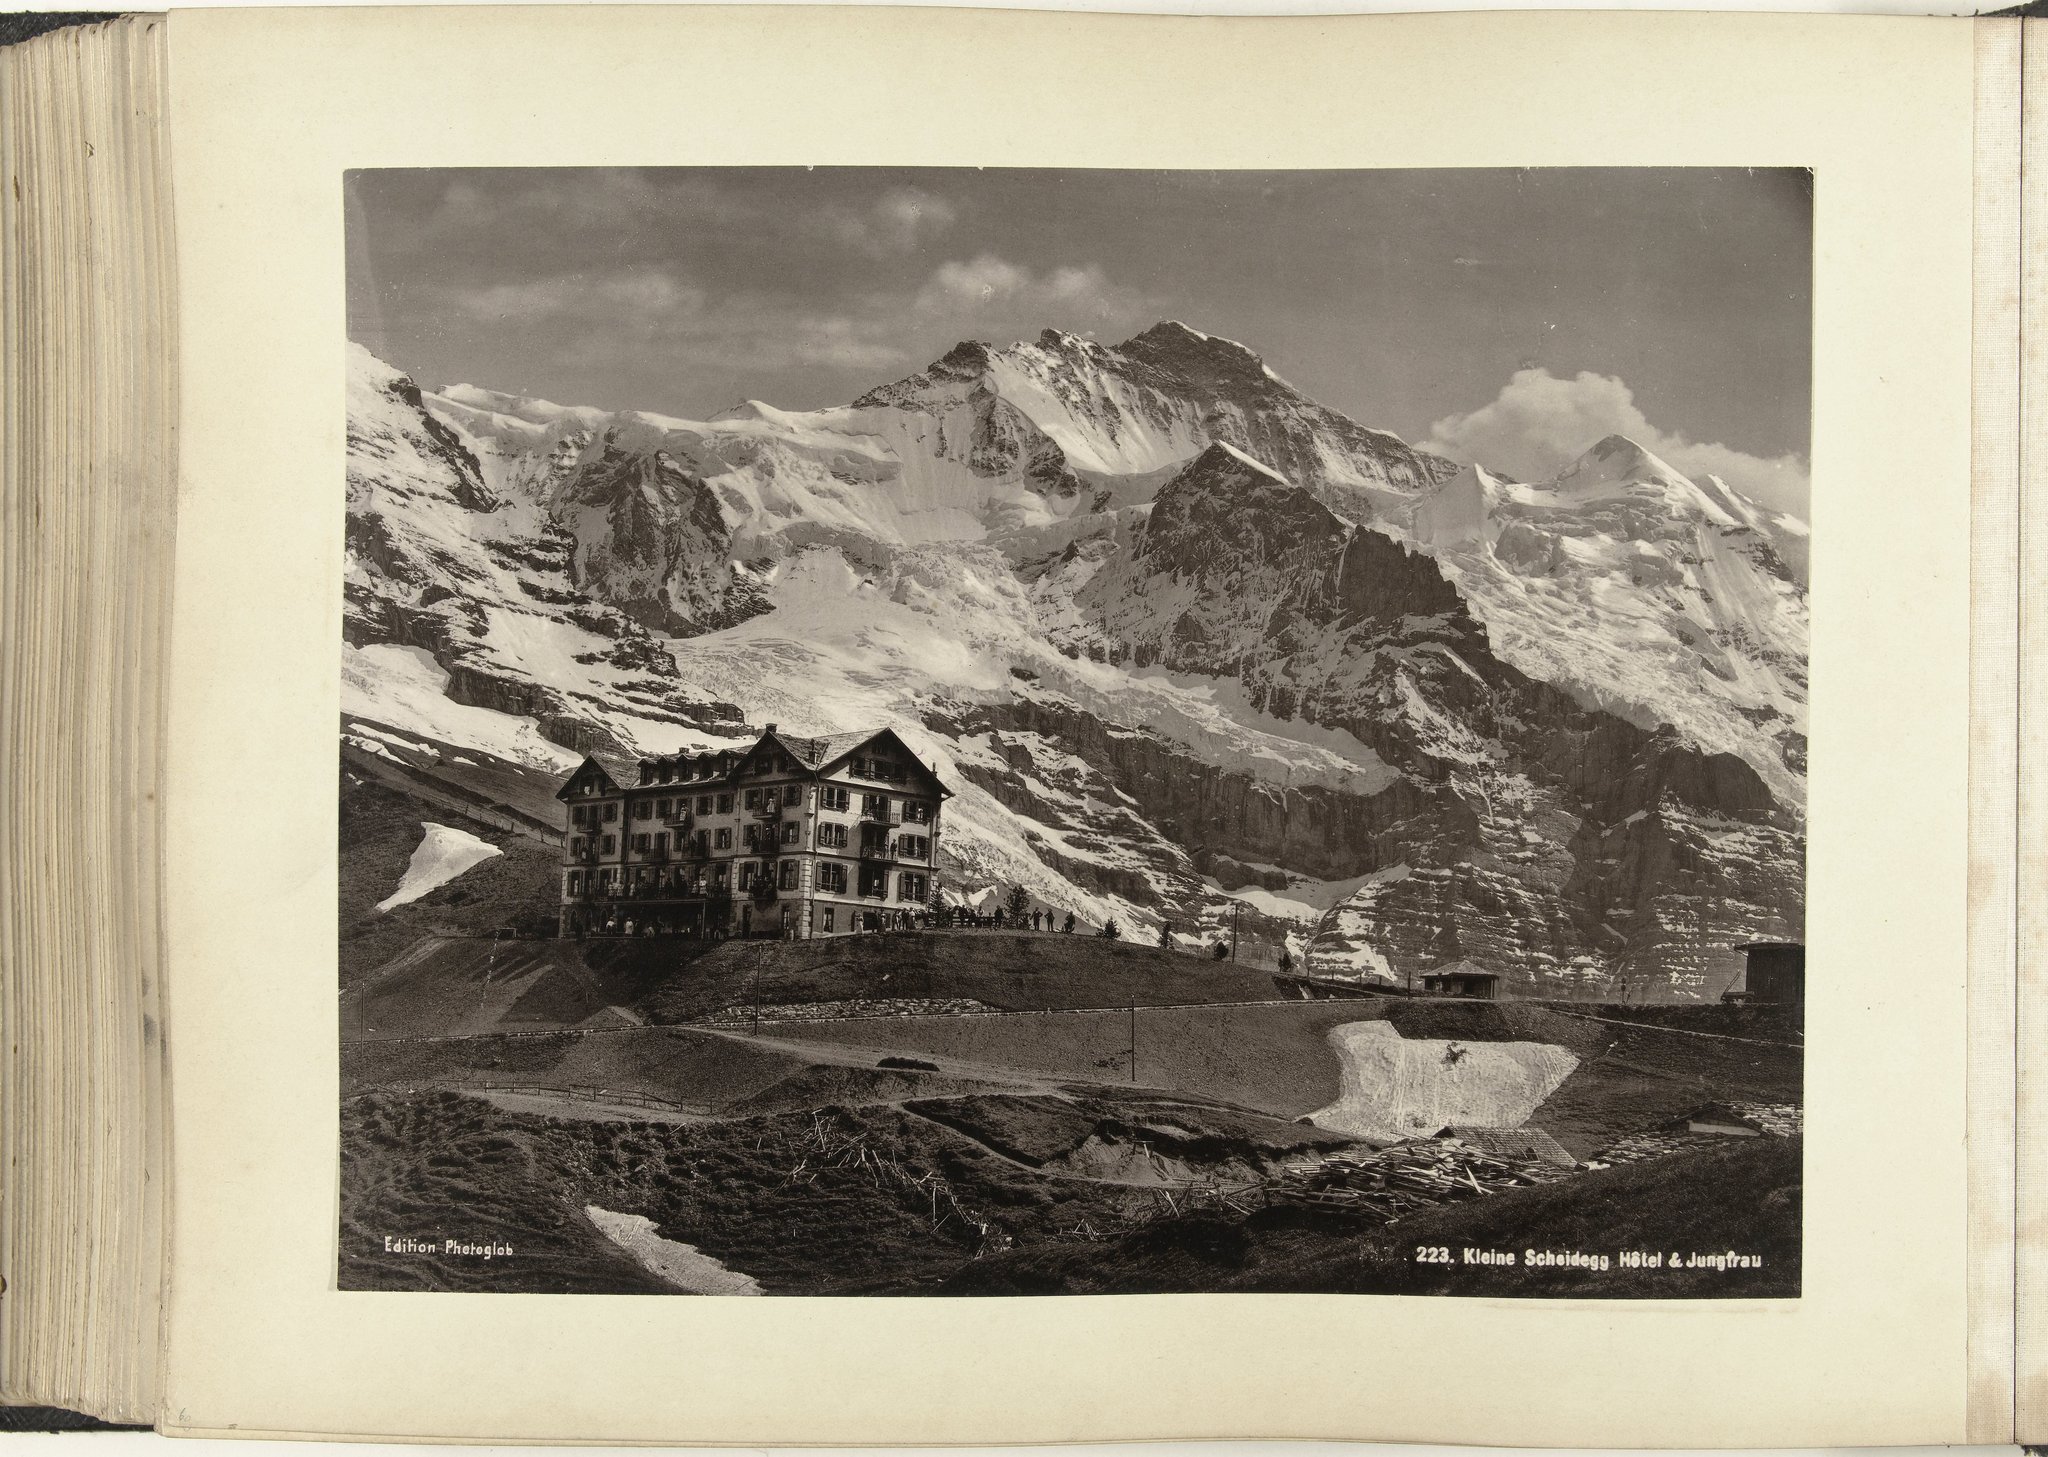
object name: photomechanical print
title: Kleine Scheidegg. Hotel & Jungfrau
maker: Anonymous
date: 1895-1910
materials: paper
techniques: photograph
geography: zurich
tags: mountain-top, peak, hotel, hostelry, inn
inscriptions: number: ‘223.’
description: Deze prent maakt deel uit van een album.